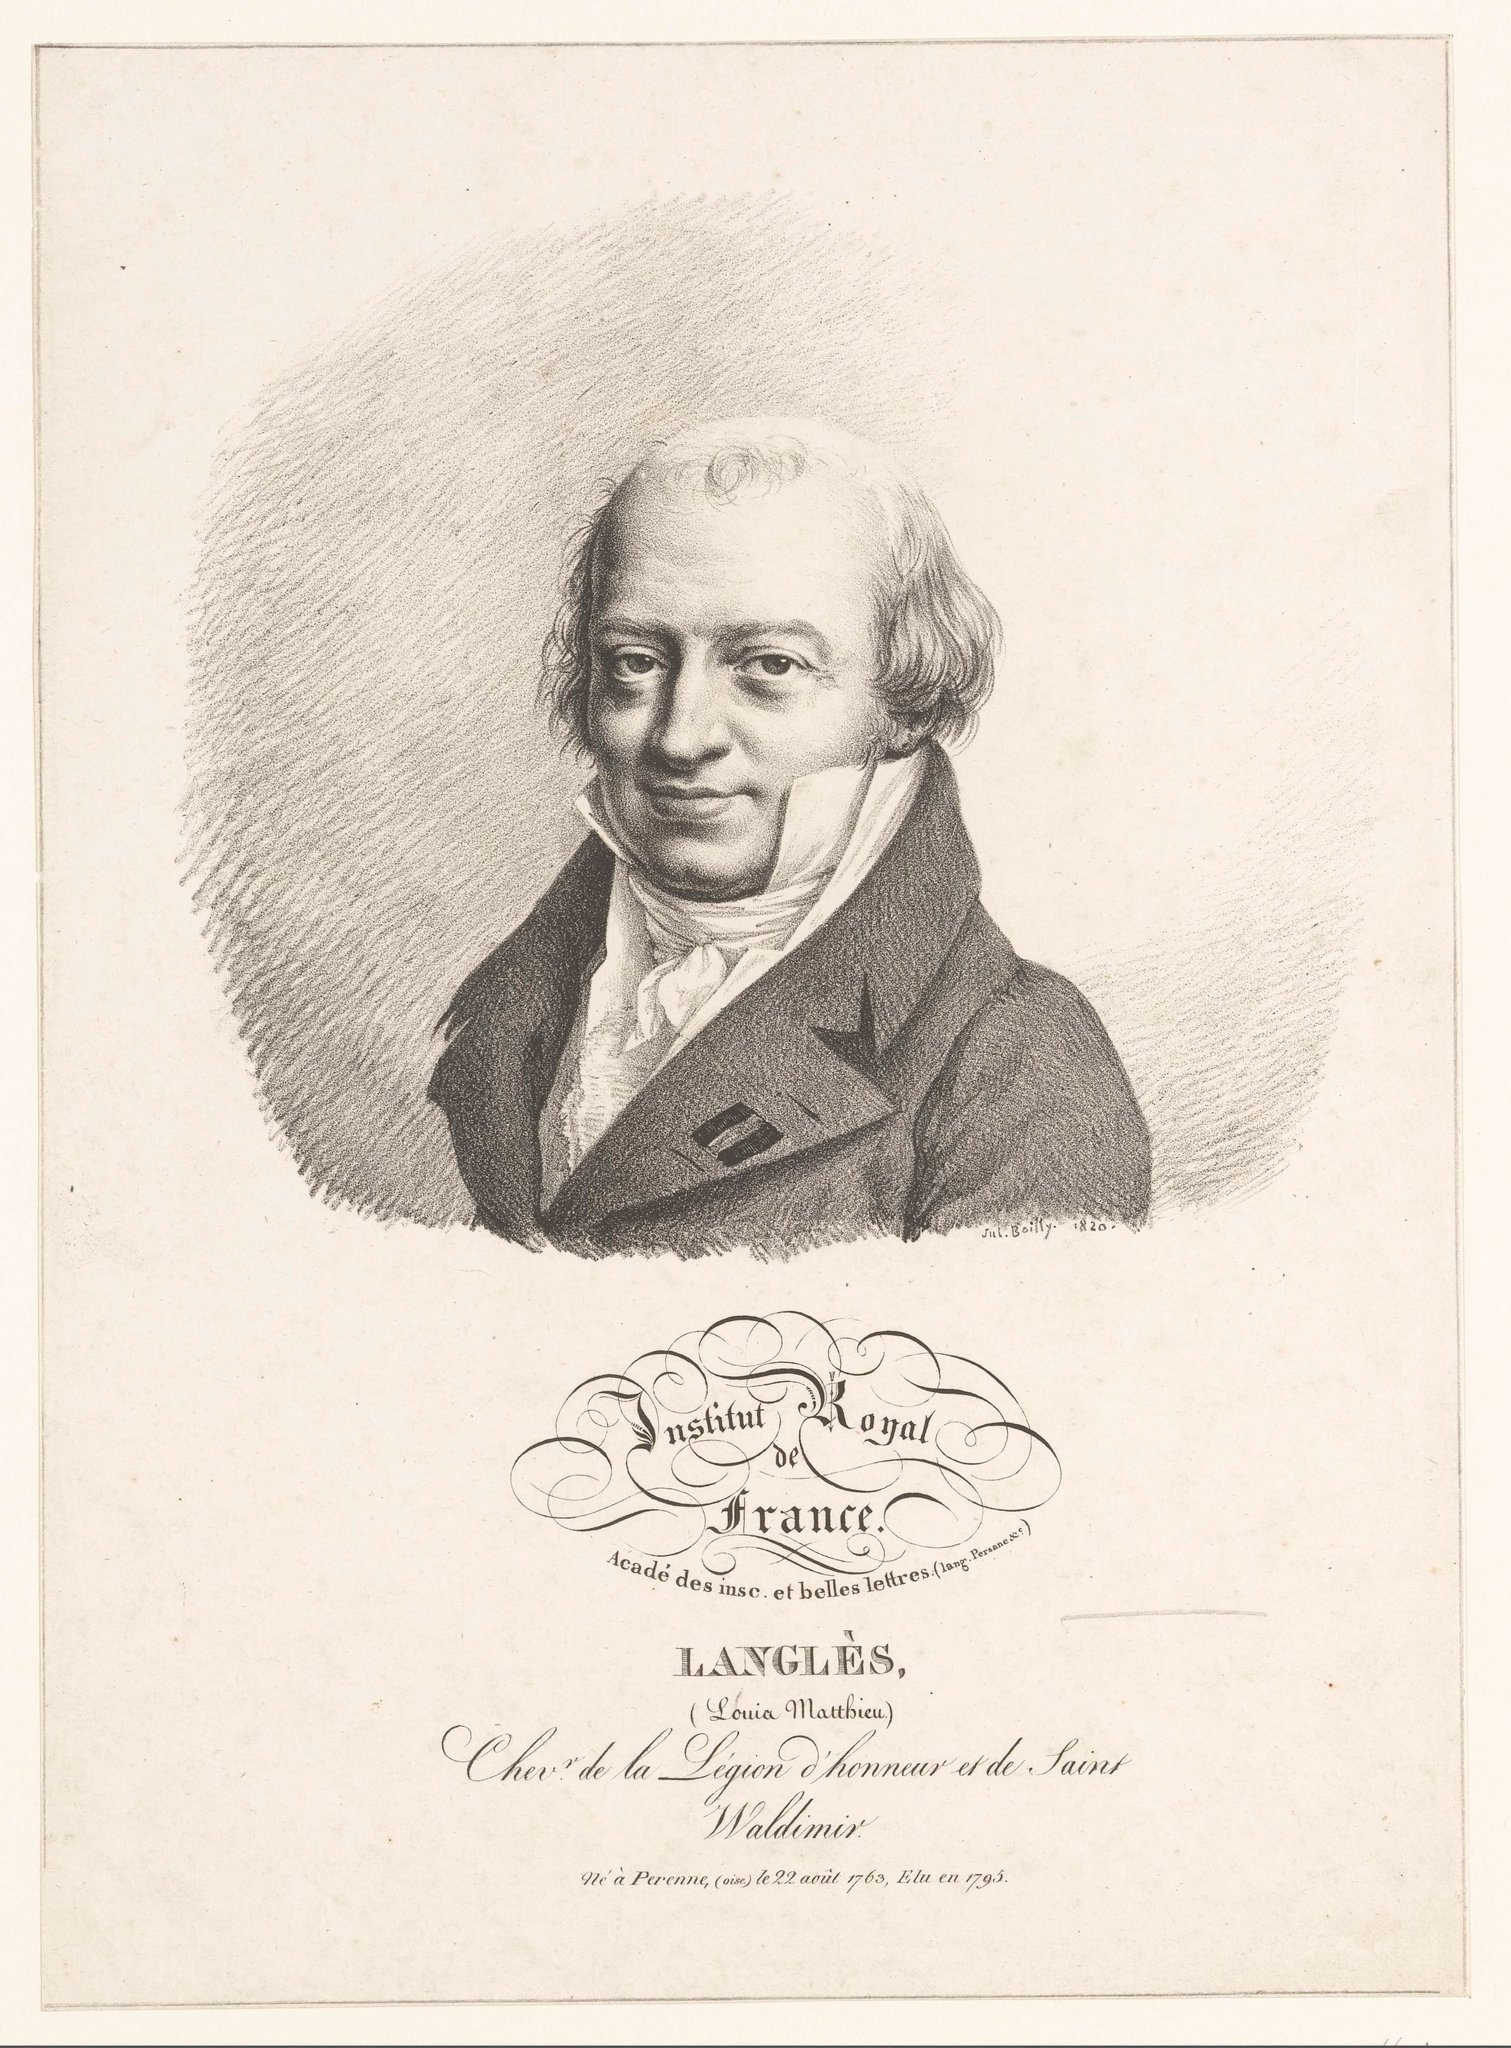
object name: print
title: Iconographie de l'Institut Royal de France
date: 1820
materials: paper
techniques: lithograph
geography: paris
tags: paris, historical persons, portrait of a writer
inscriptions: collector's mark: Lugt 2228a